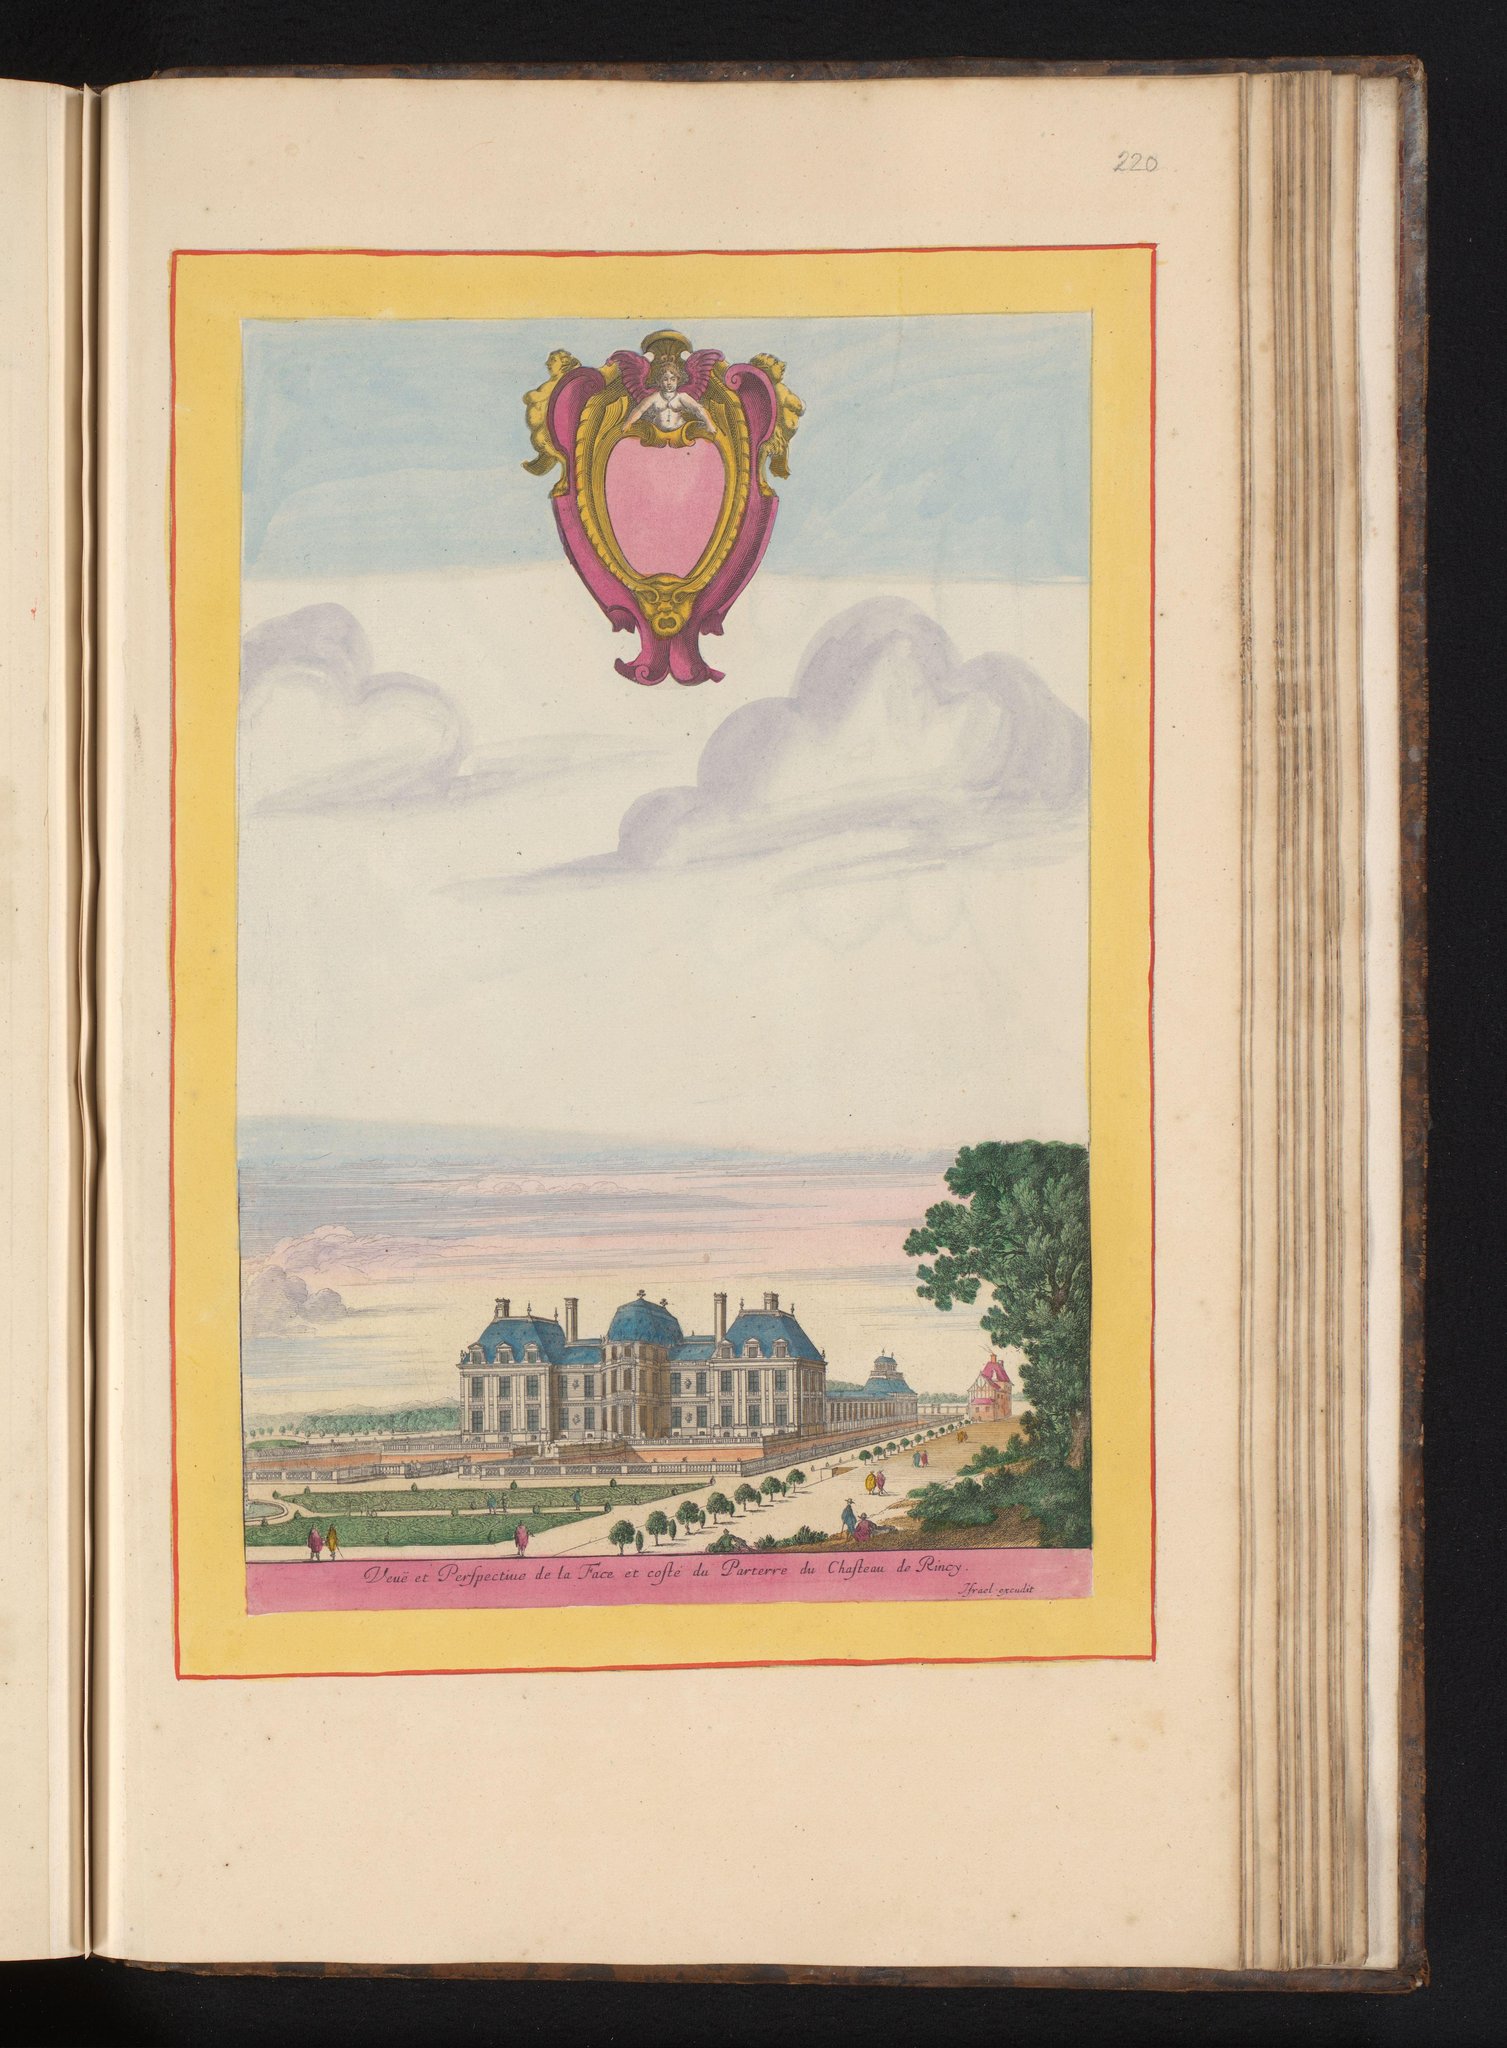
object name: album leaf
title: Veuë et Perspective de la Face et costé du Parterre du Chasteau de Rincy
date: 1631-1661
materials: paper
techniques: etching, hand coloring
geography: paris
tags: castle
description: Gezicht op Château du Raincy vanaf de tuinen. In de lucht een ornamenteel leeg wapenschild. Prent maakt deel uit van een album.